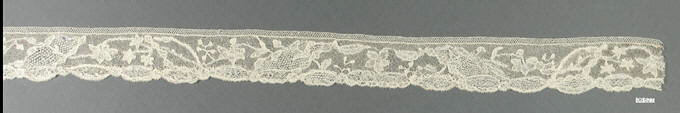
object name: strip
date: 1767-1800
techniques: lace